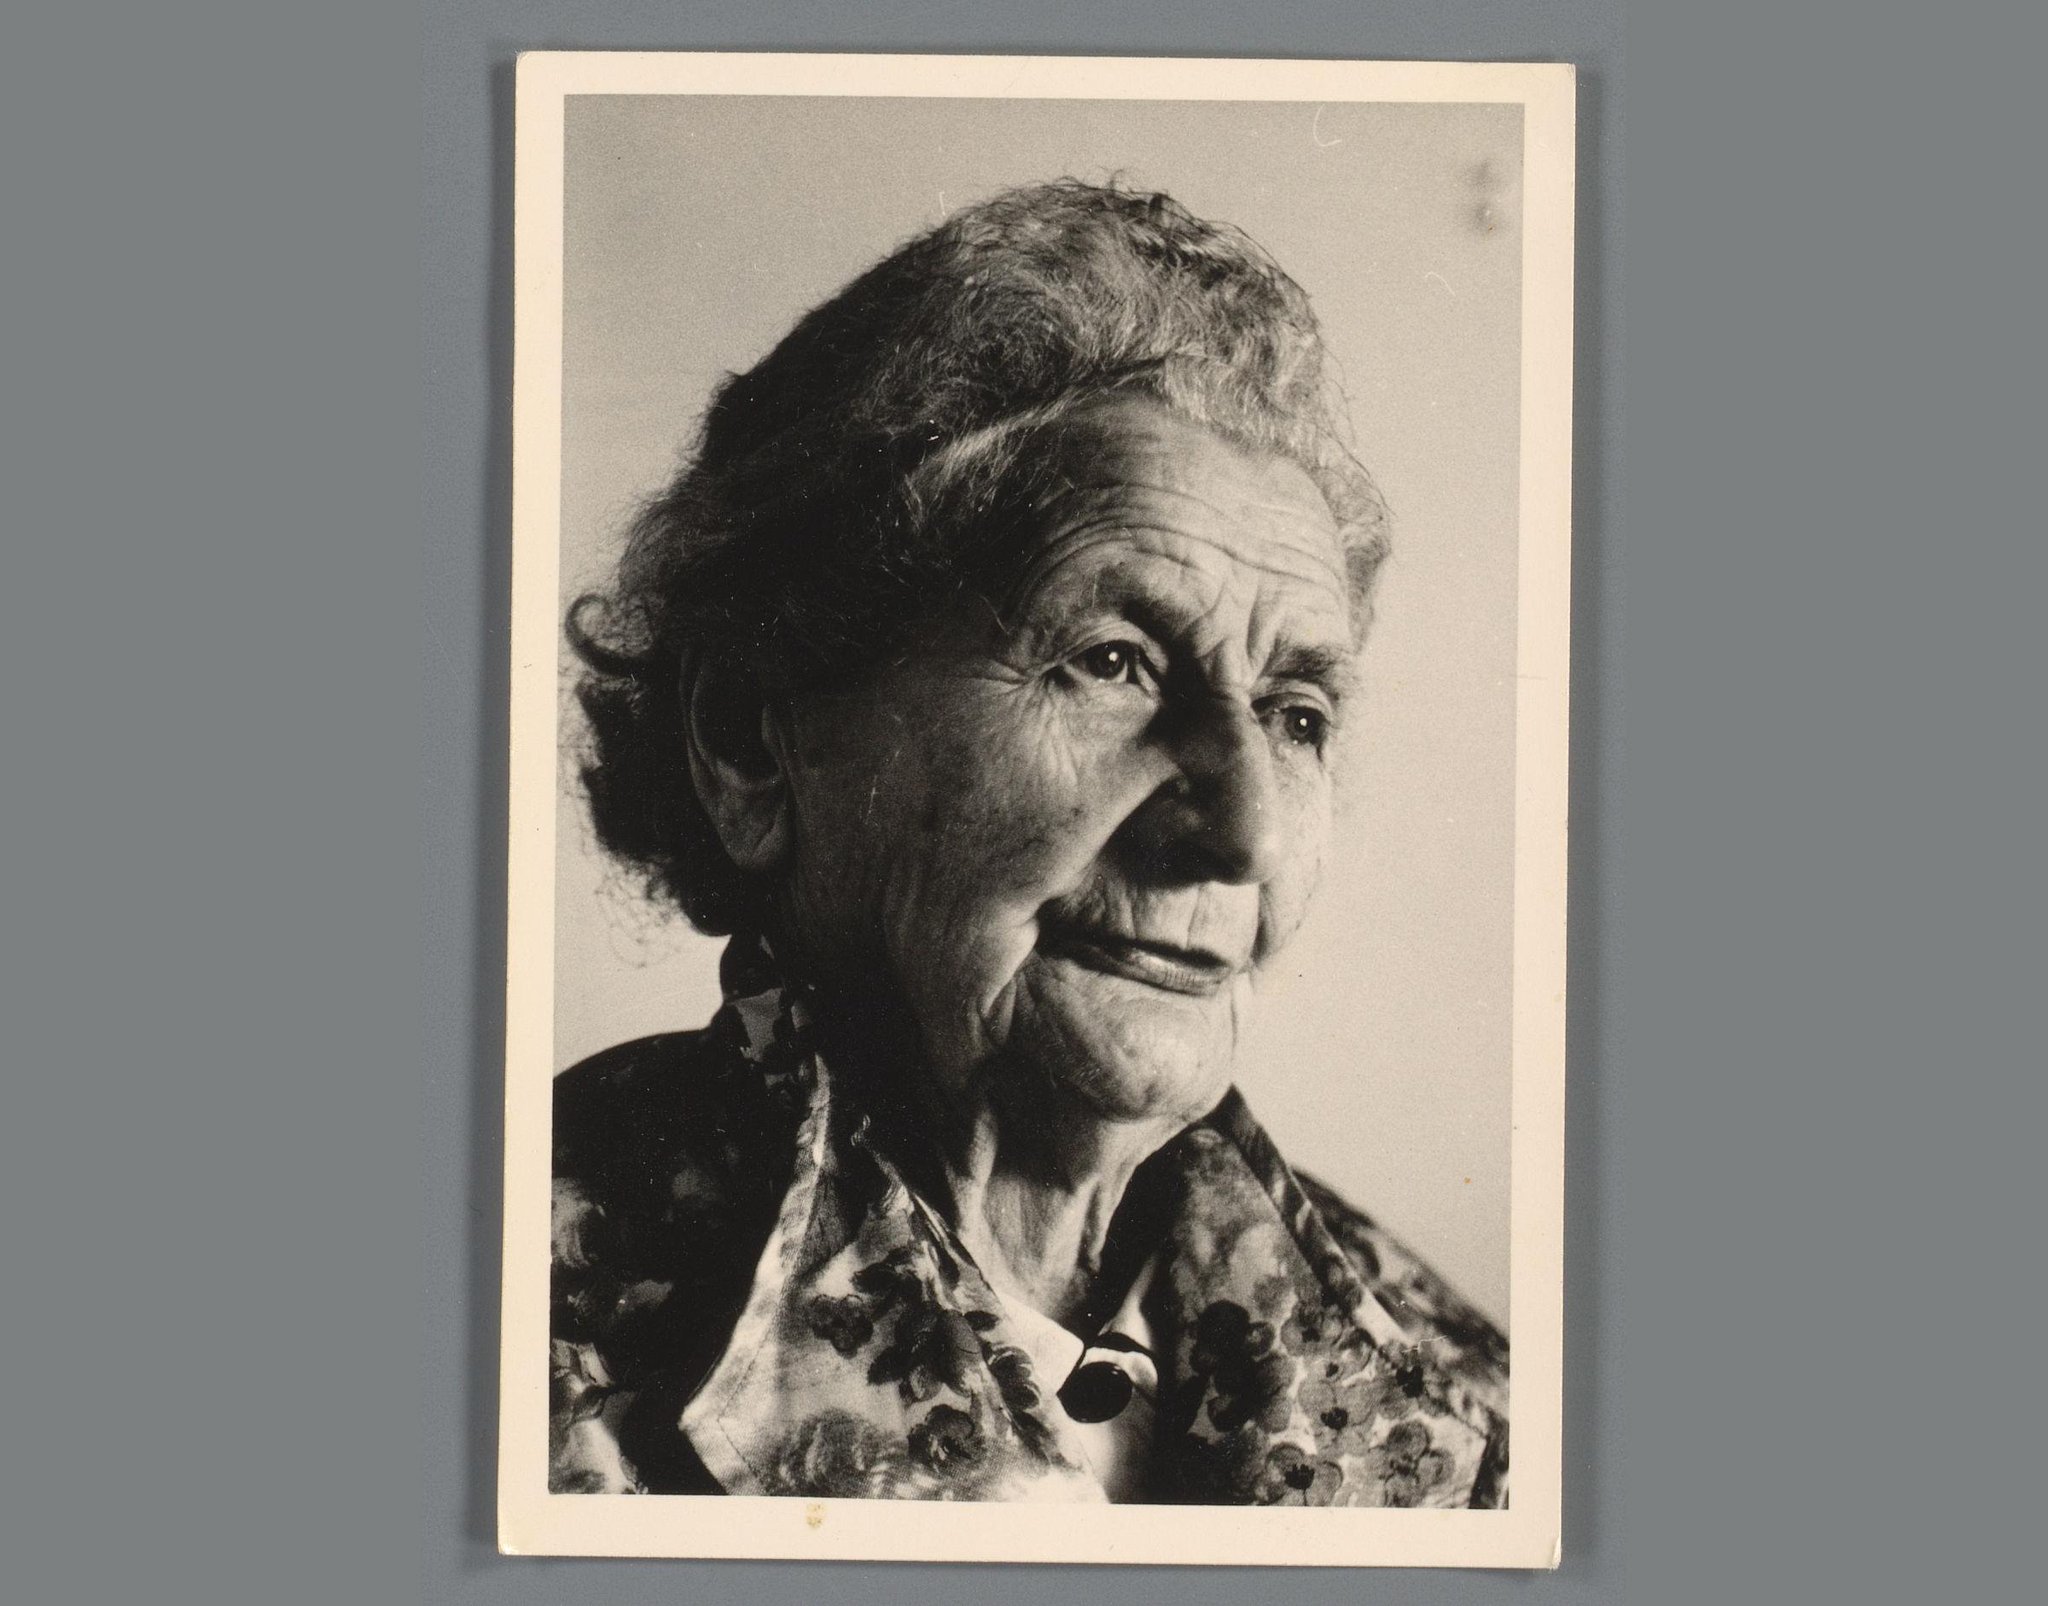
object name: photograph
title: Portret van Cornelia Wilhelmina Polman op bidprent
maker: Anonymous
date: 1965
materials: paper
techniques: gelatin silver print, letterpress printing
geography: bussum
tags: historical persons, old woman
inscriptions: inscription: ‘Ter nagedachtenis aan (...) hun moeder te herinneren om e beoeofening van alle/ deugden te leren. St. Augustinus’